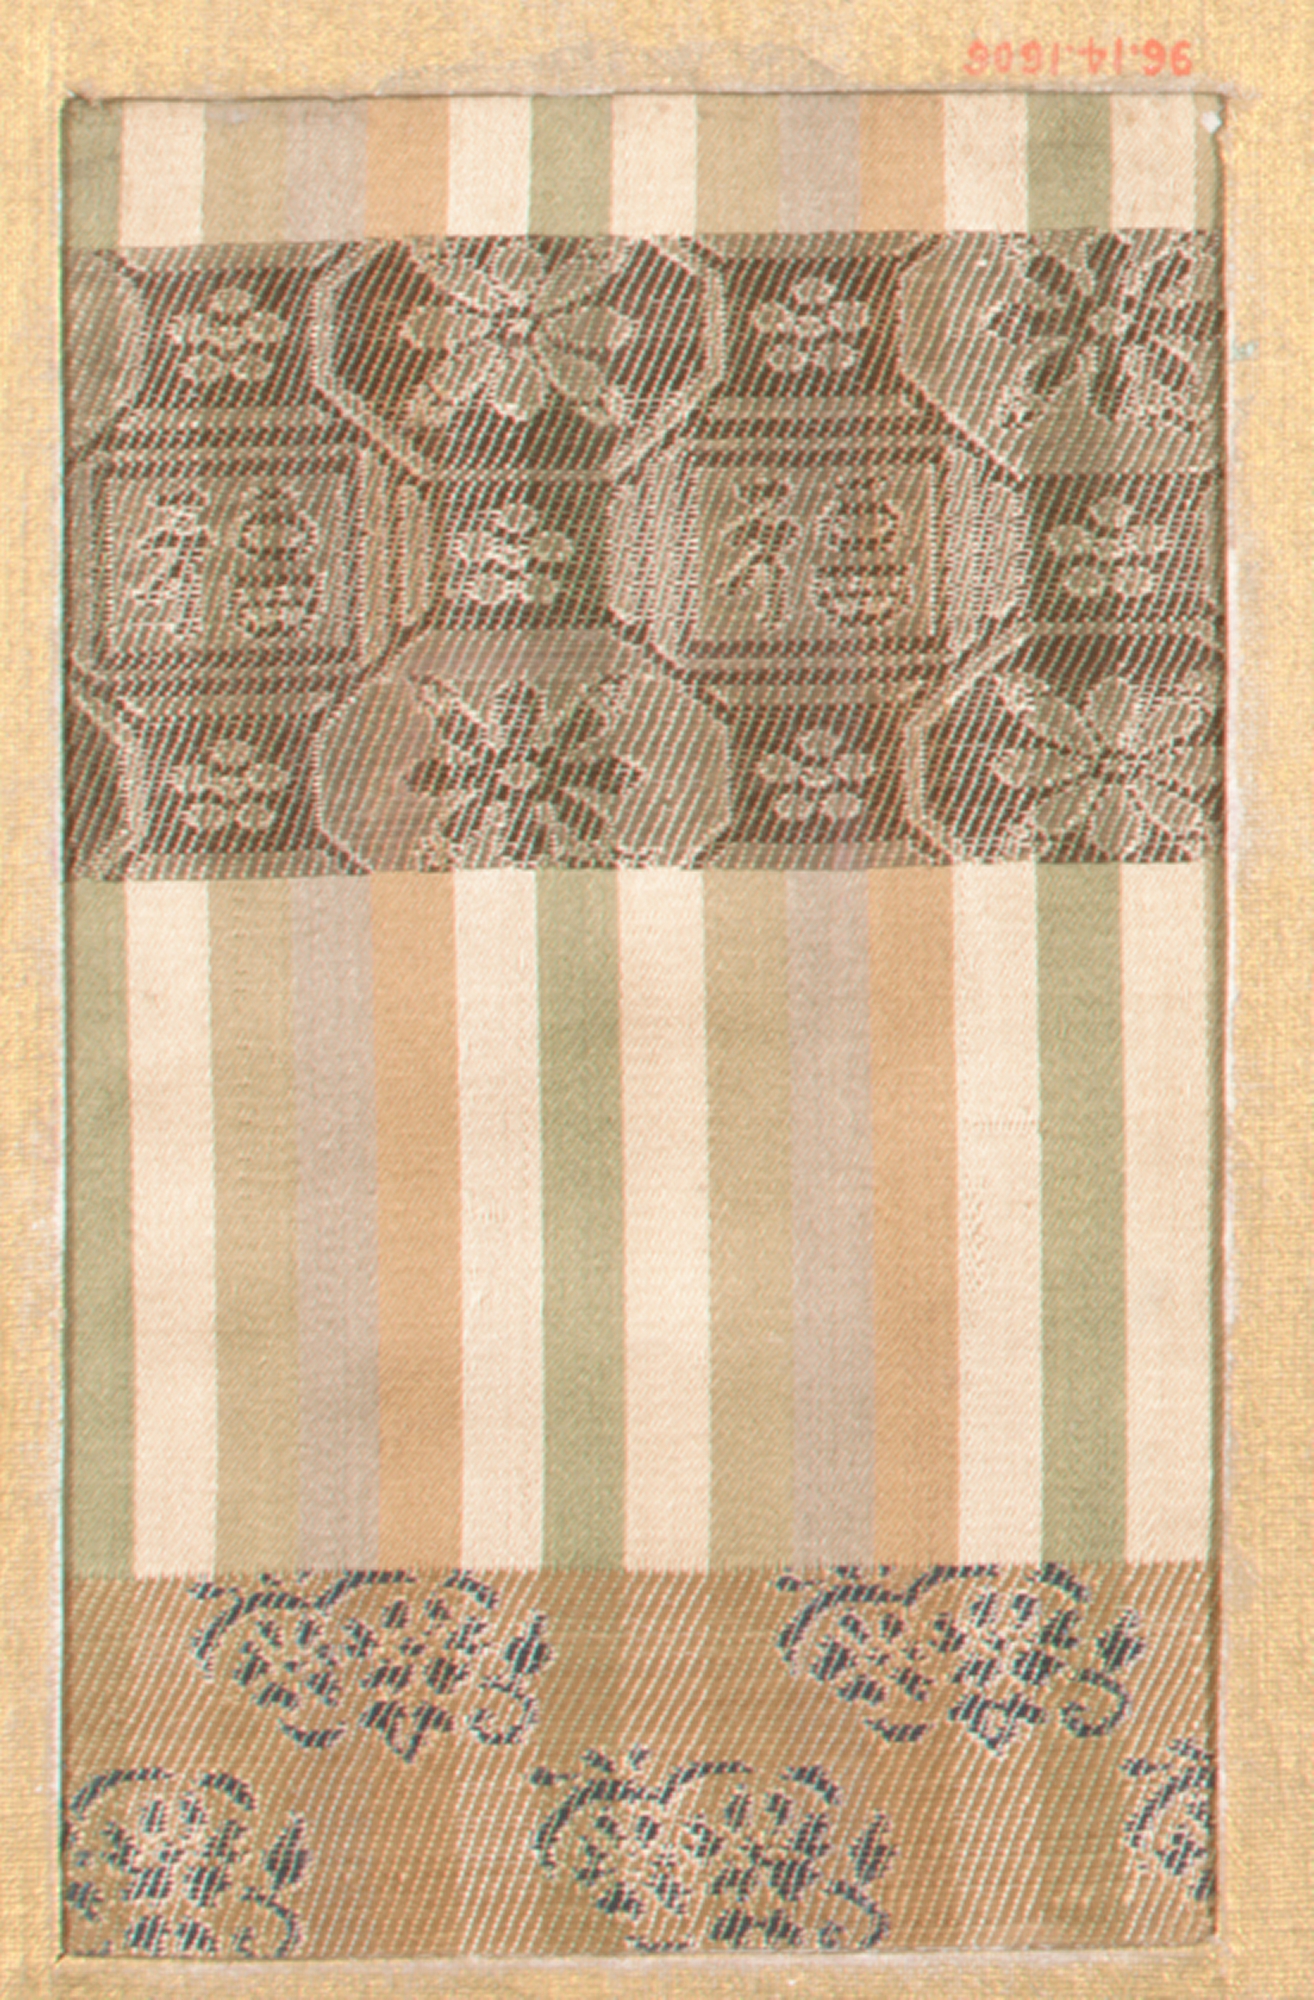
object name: piece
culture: japanese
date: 1701-1900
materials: silk